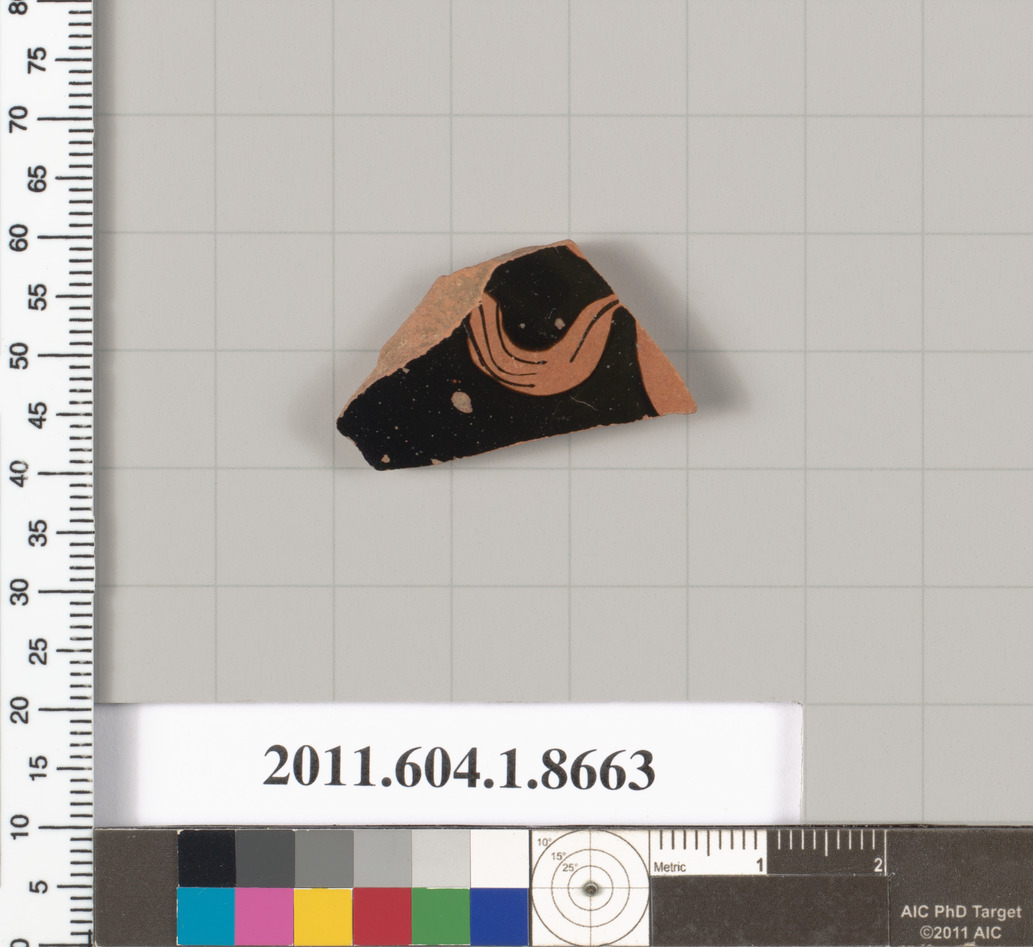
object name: kylix fragment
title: Terracotta rim fragment of a stemless? kylix (drinking cup)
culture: greek, attic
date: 467-435 BCE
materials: terracotta